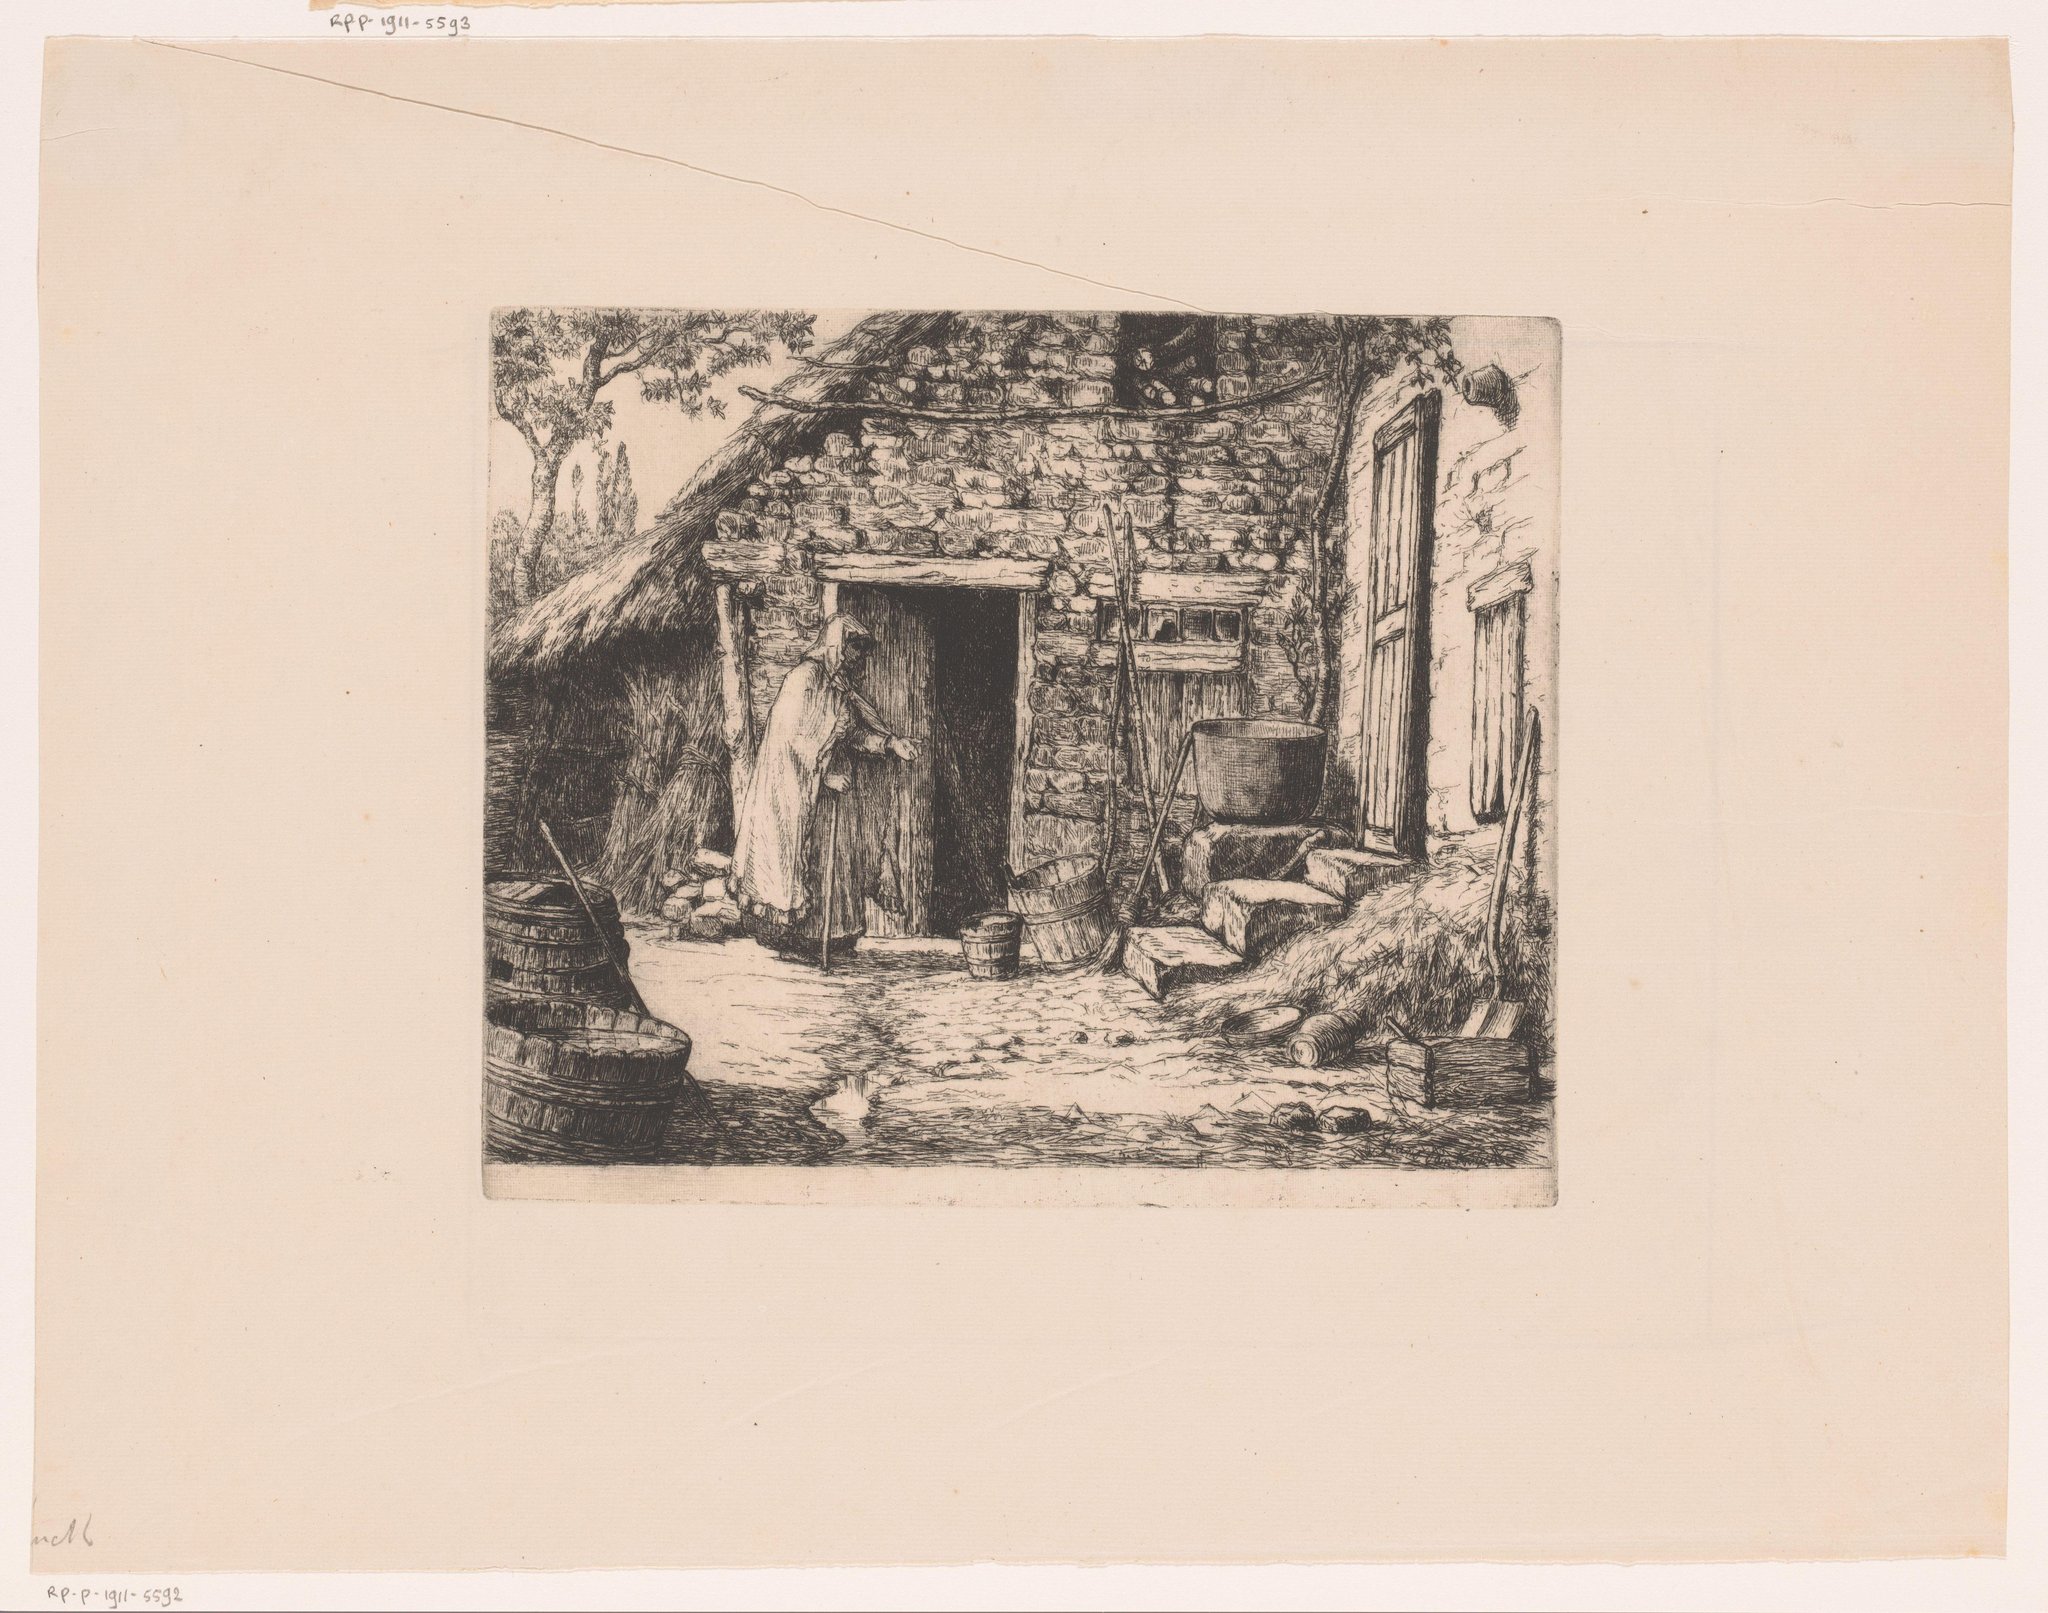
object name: print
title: Bedelaar aan de deur bij een boerderij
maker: frans van kuyck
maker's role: painter, print maker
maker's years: 1852-1915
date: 1862-1911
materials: paper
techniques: etching, intaglio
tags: beggar, farm (building)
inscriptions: collector's mark: Lugt 2228